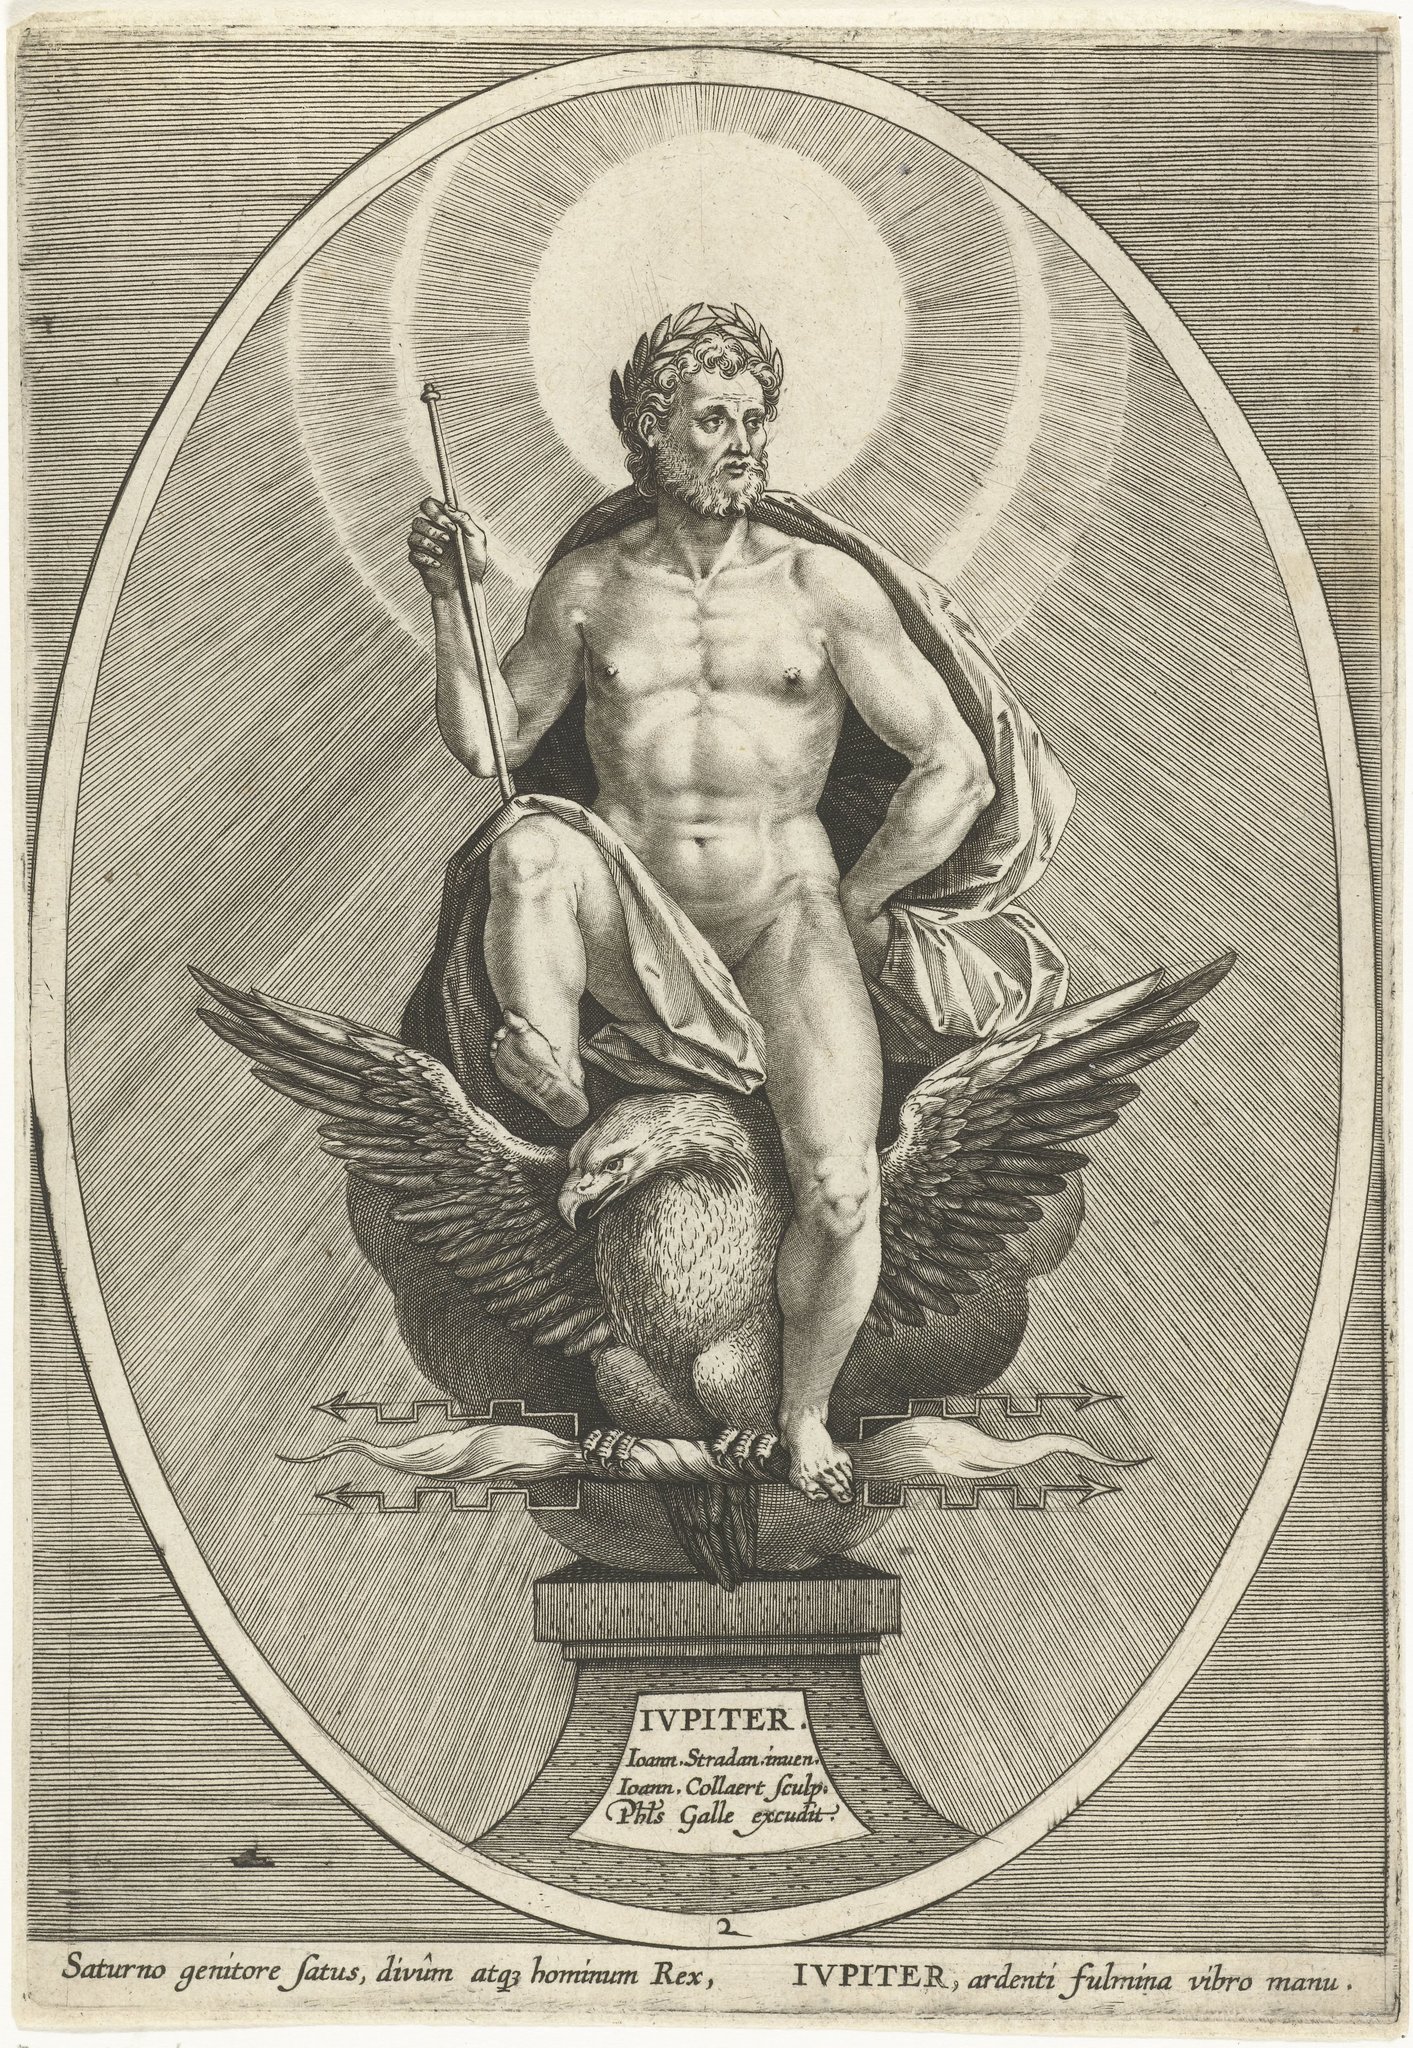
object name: print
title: Jupiter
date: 1585-1628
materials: paper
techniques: engraving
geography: florence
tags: (story of) jupiter (zeus), jupiter (planet)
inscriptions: collector's mark: Lugt 2228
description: Ovale lijst met centraal op een sokkel de naakte god Jupiter. Hij zit op een adelaar. De prent heeft een Latijns onderschrift en maakt deel uit van een serie over de zeven planeten en hun goden.